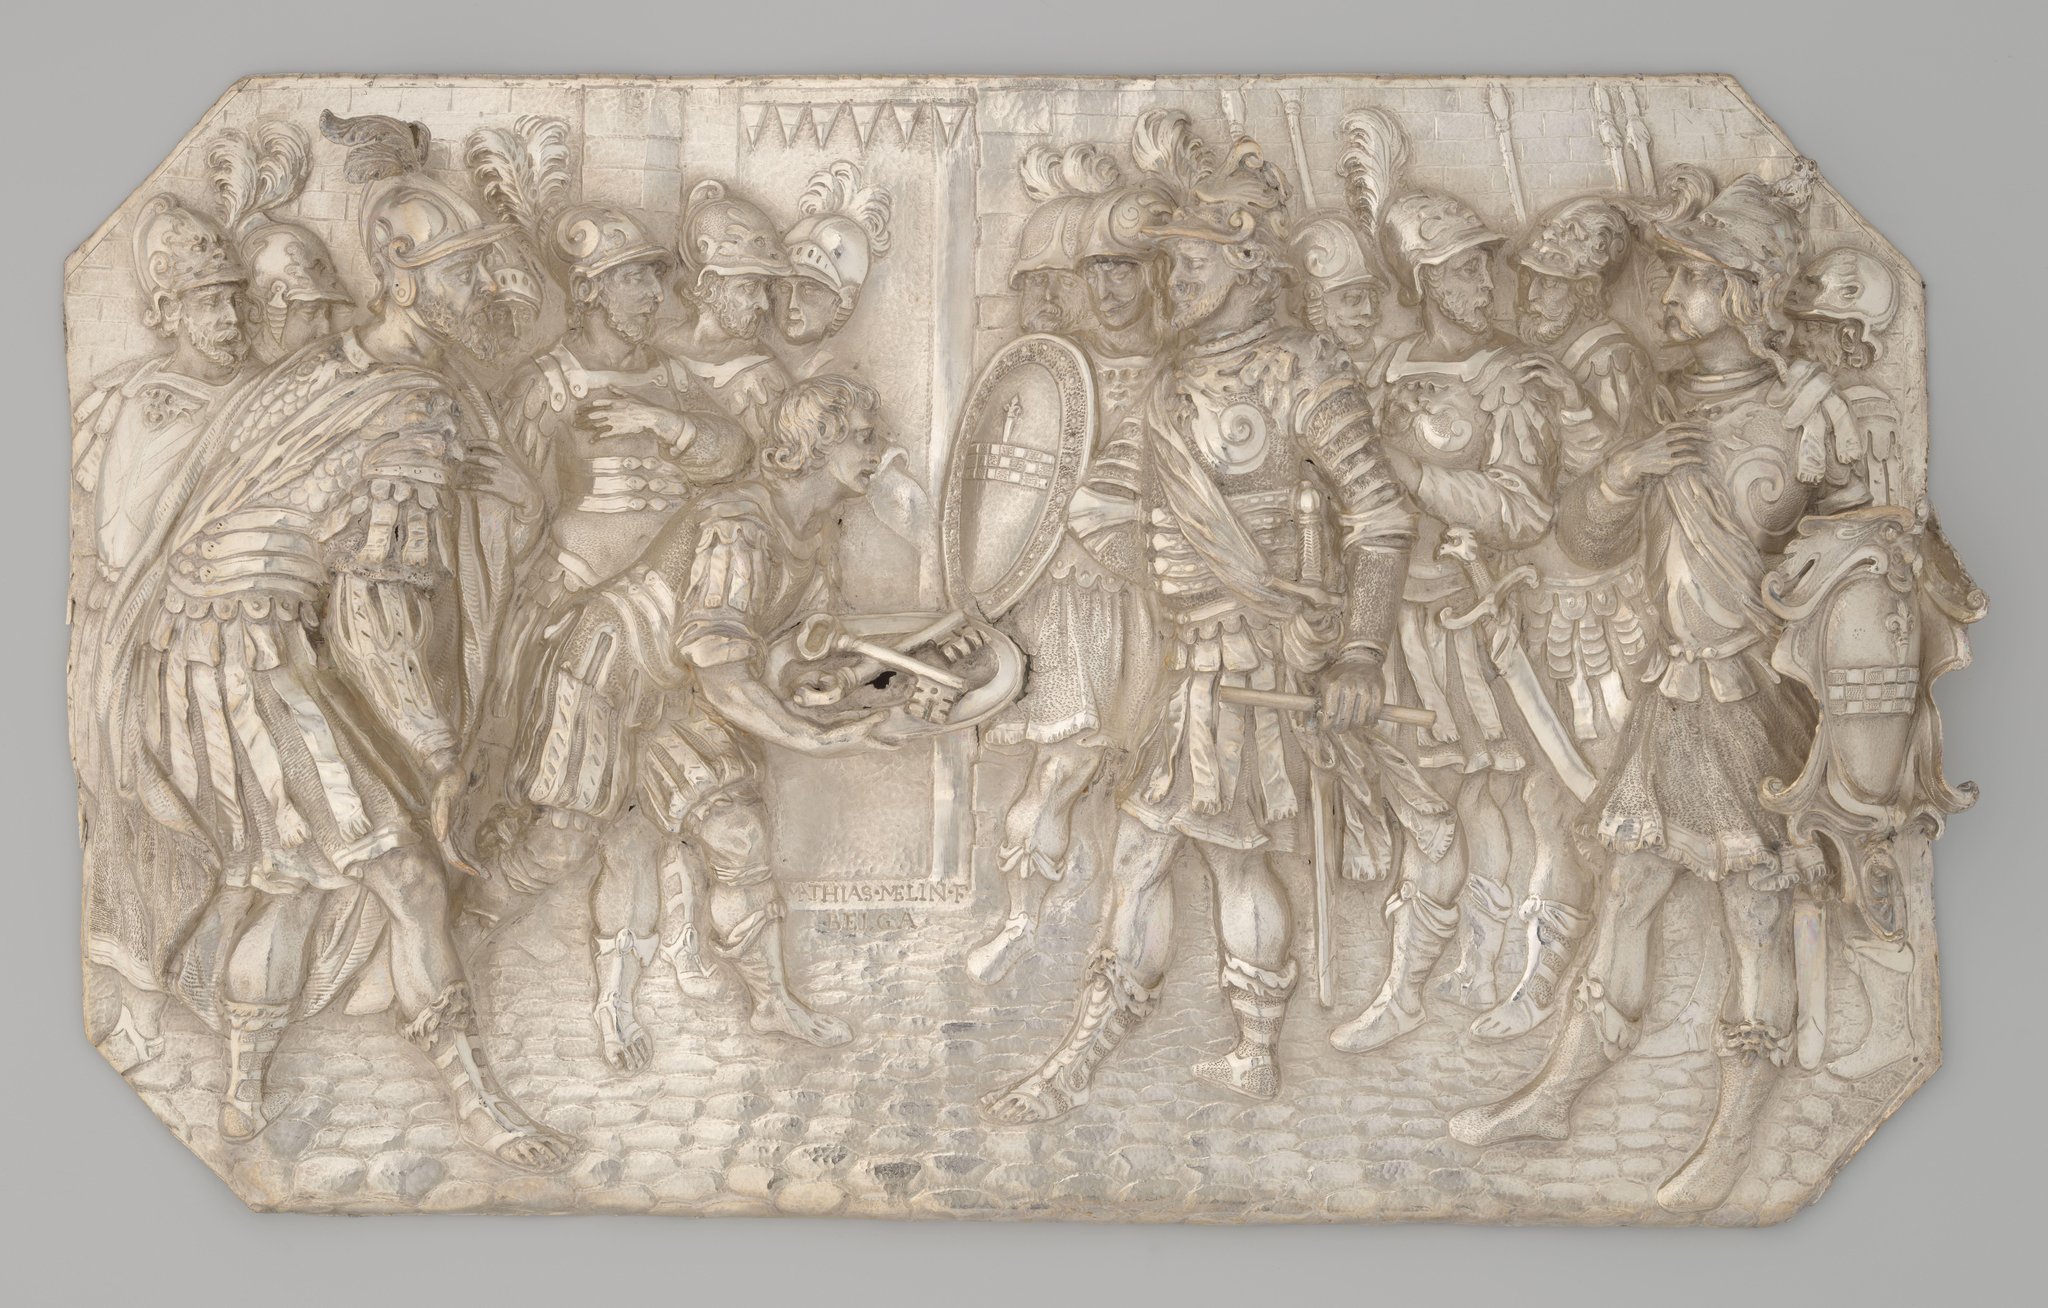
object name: plaque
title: Box with Episodes from the Life of the Spinola Family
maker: mattheus melijn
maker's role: silversmith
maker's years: 1588-1653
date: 1636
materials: silver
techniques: repoussé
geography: southern netherlands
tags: surrender of keys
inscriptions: signature: ‘Mathias Melin F. Belga’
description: In the 17th century various silversmiths from the Netherlands were active in the Italian city of Genoa. They were celebrated for their skills in rendering stories in very high relief. These plaquettes are made by the most famous of these craftsmen, Mattheus Melijn of Antwerp. They feature episodes from the life of the Spinola family, and show how a city can be conquered: Maria Spinola procured a duchy through the power of love, her brother Ambrogio through military might. Gianbattista Spinola here receives the keys to the Duchy of San Pietro in Galatina (Sicily). From then on, he and his wife Maria Spinola were the duke and duchess and were adored by the people.